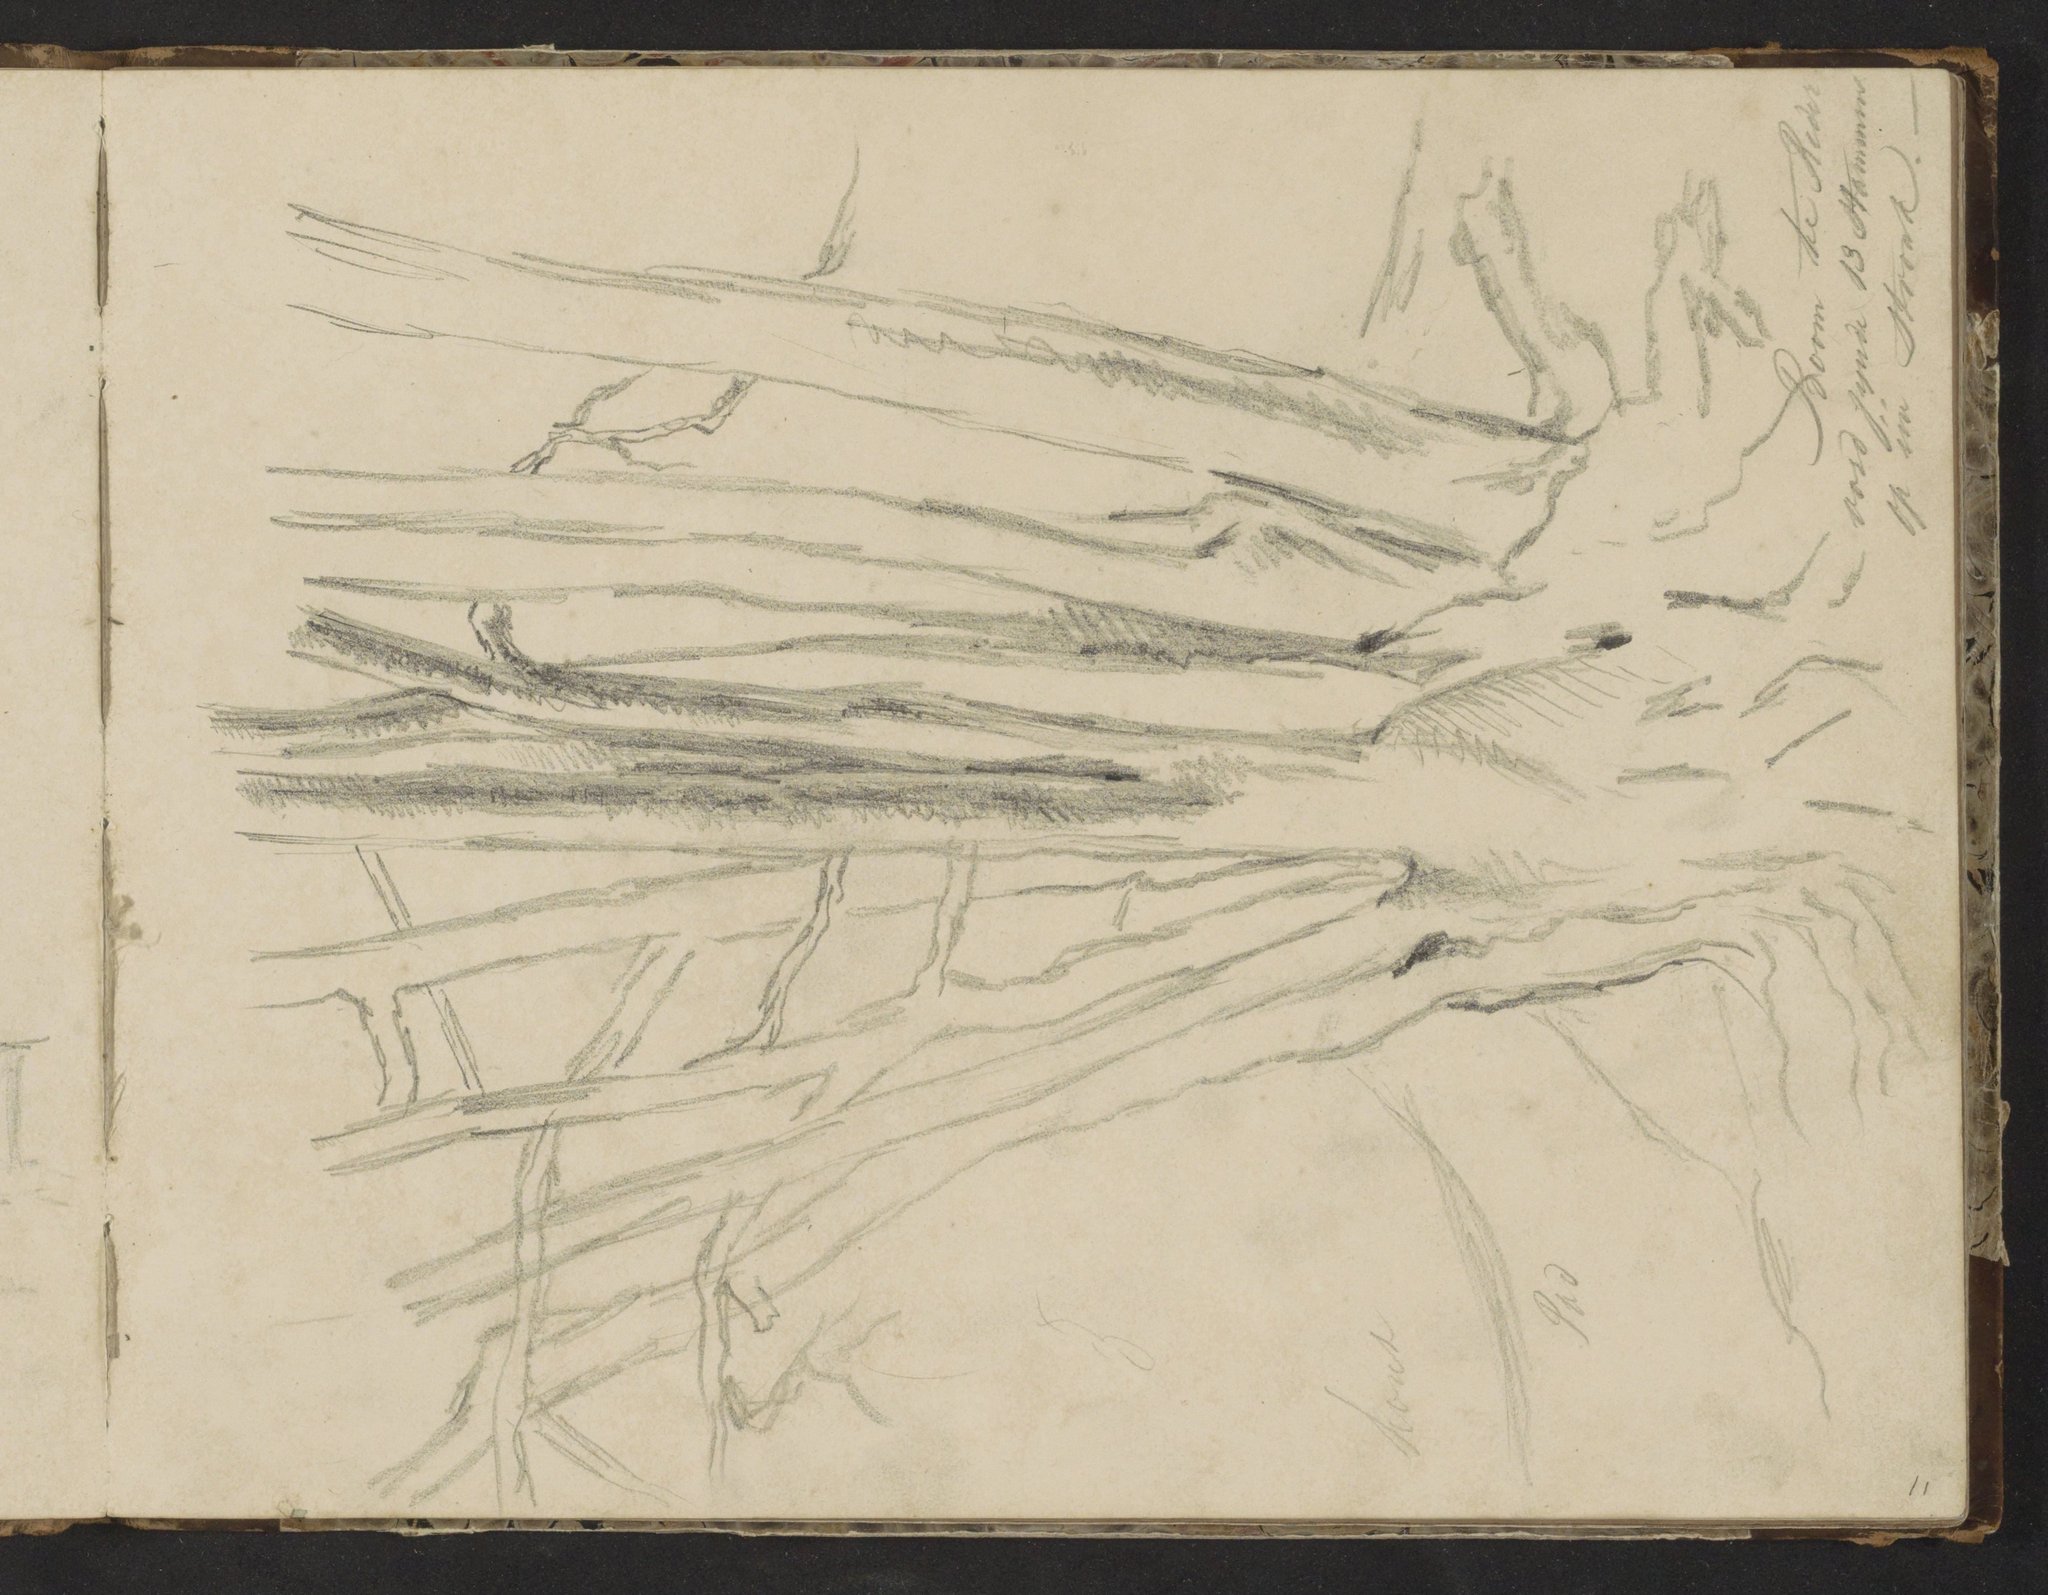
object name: sketchbook leaf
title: Boom met dertien stammen op het landgoed Rhederoord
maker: johannes tavenraat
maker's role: draughtsman, painter, print maker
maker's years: 1809-1881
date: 1833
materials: paper, pencil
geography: gelderland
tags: trees, gelderland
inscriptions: annotation: ‘hout/ Pad/ Boom te Reder-/ oord zijnde 13 stammen/ op één stronk.-’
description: Blad 11 recto uit een schetsboek met 41 bladen.